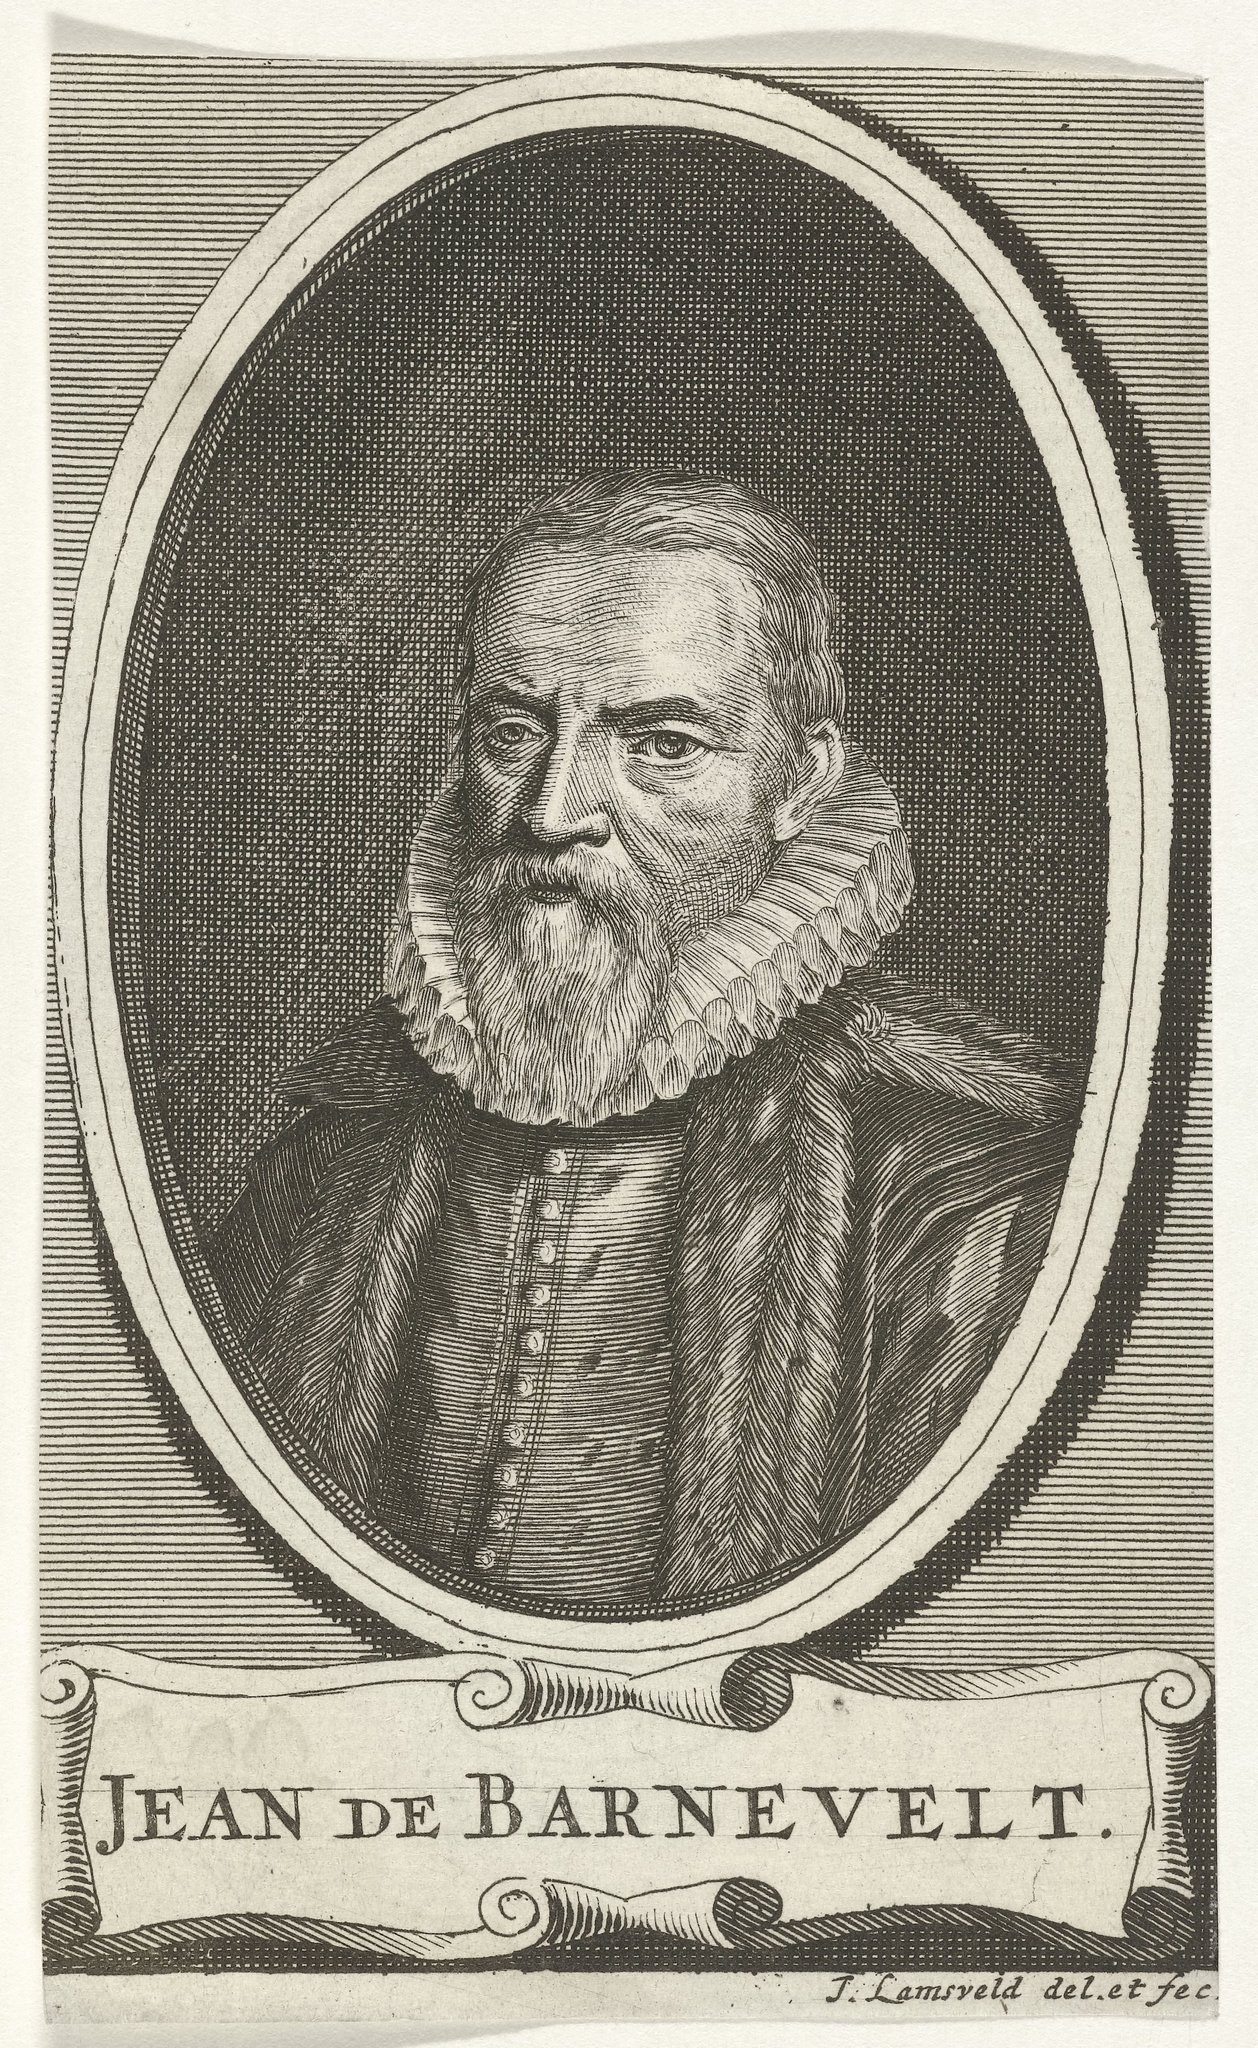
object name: print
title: Jean de Barnevelt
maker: jan lamsvelt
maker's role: print maker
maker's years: 1674-1743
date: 1684-1743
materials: paper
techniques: engraving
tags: the hague, johan van oldenbarnevelt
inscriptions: collector's mark: Lugt 2228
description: Portretbuste in ovaal naar links van Johan van Oldenbarnevelt, blootshoofds en gehuld in een met bont afgezette mantel. Onder het portret staat de naam van de geportretteerde